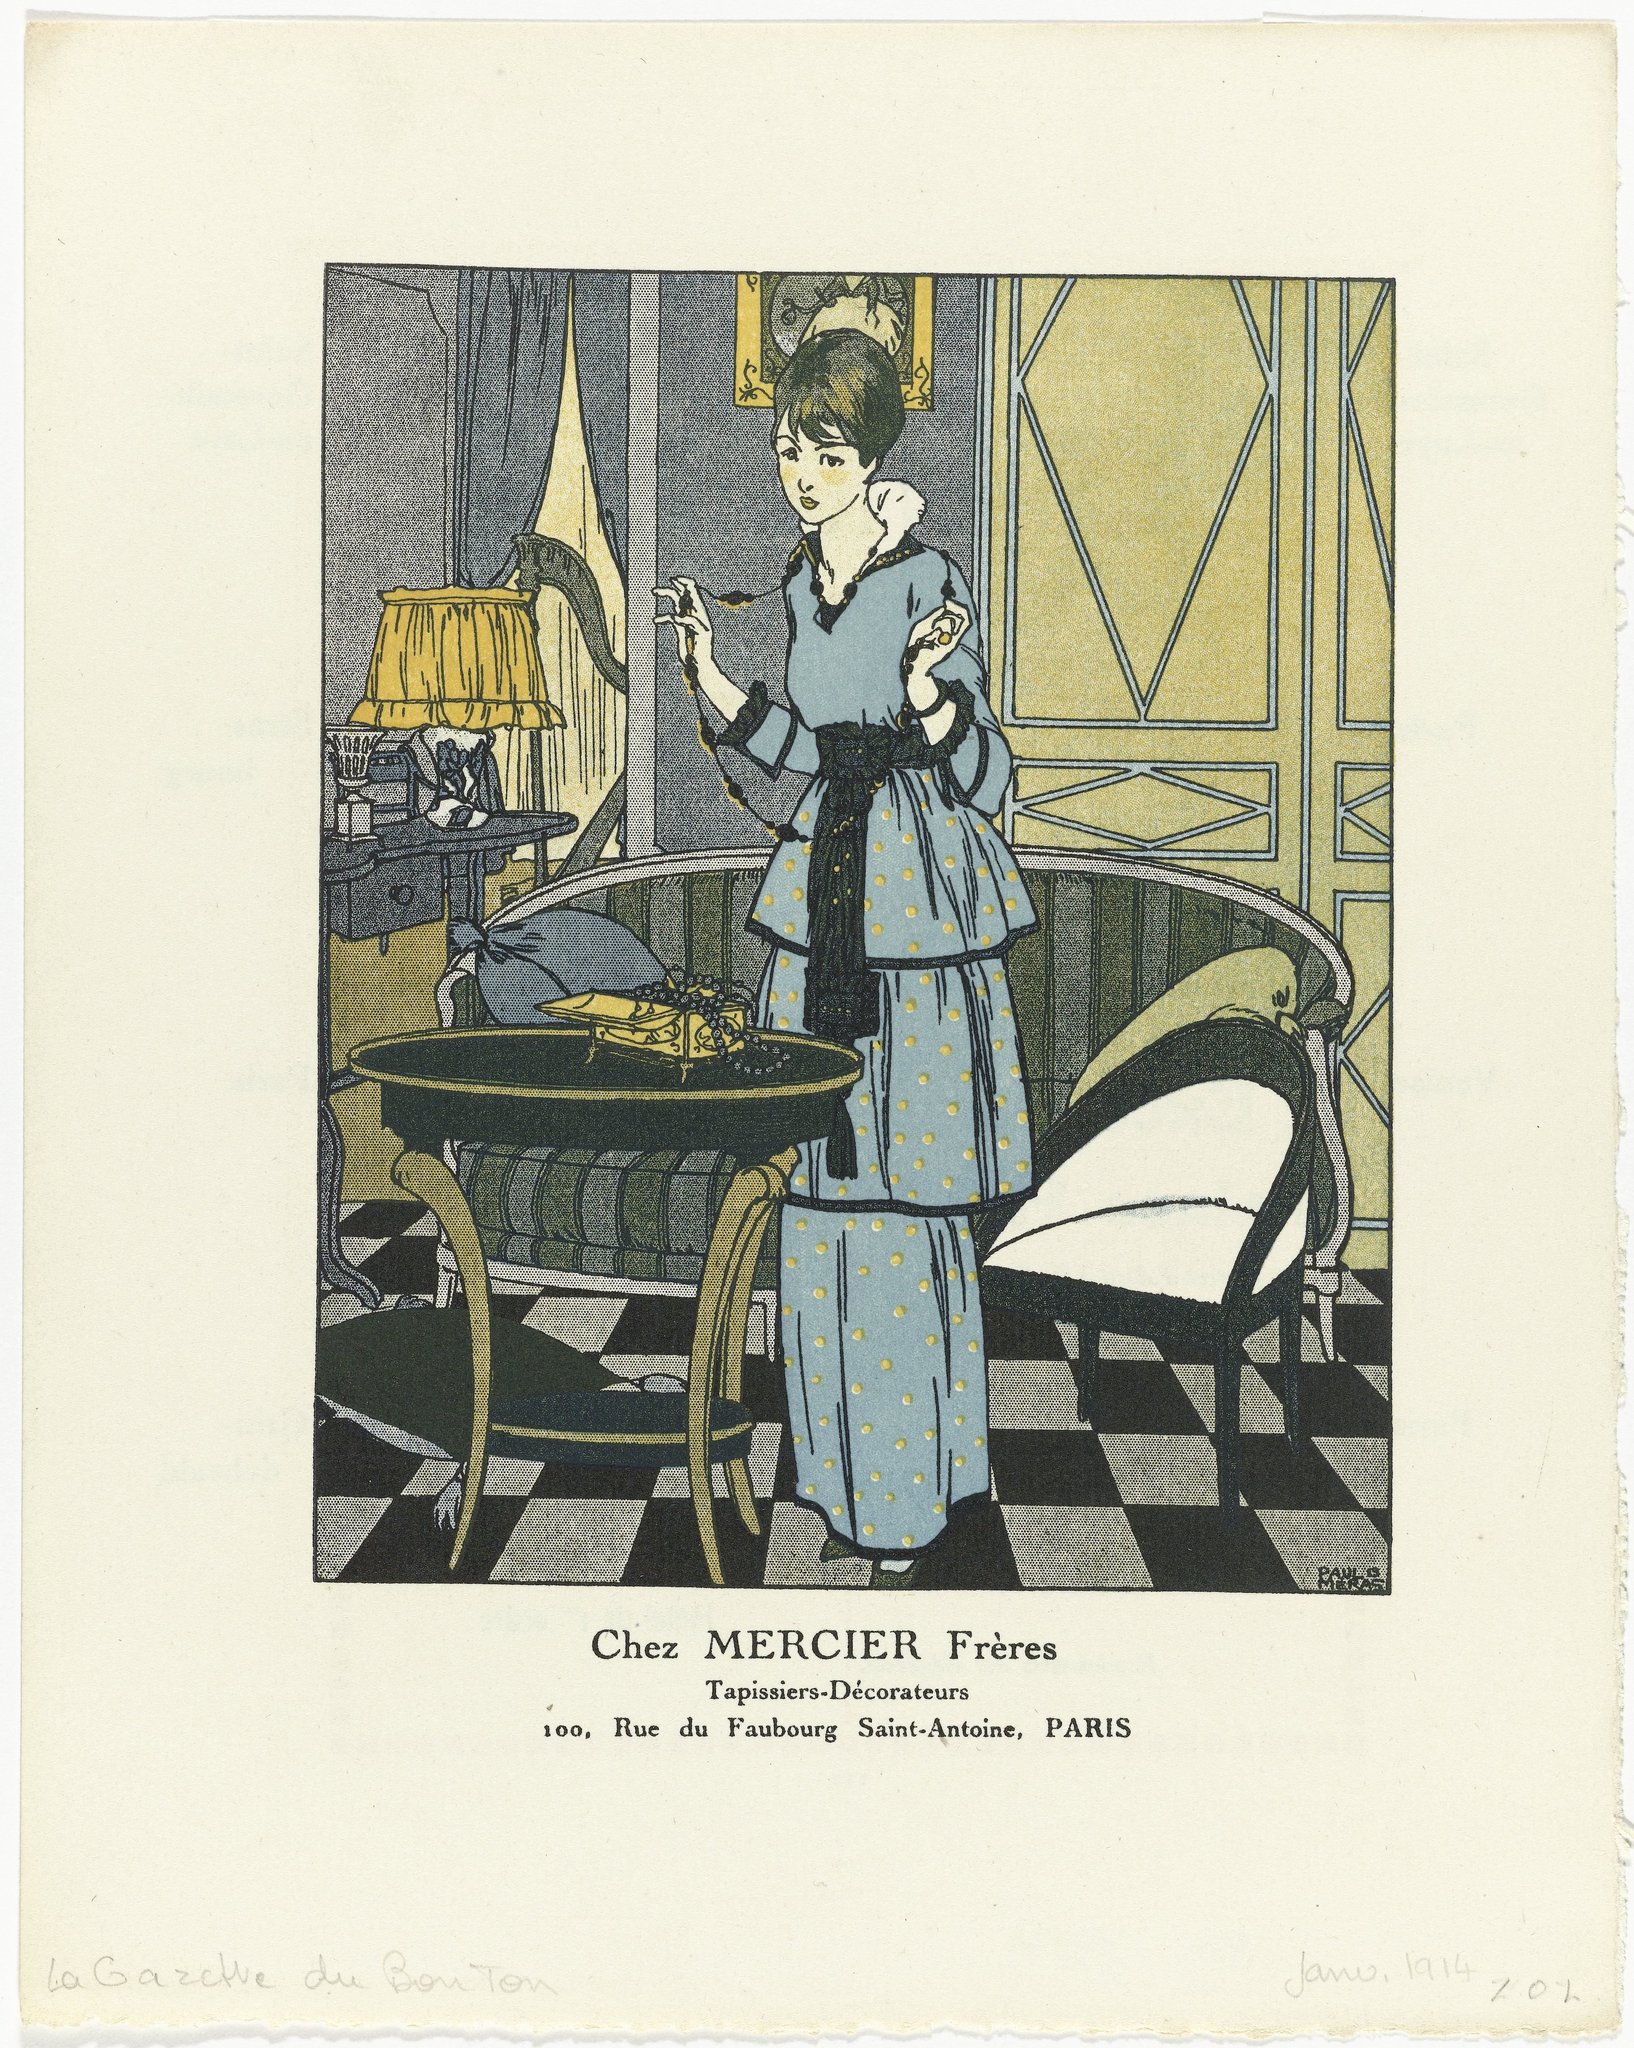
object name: fashion print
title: Gazette du Bon Ton, 1914 - No. 1: Chez MERCIER Frères / Tapissiers - Décorateurs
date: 1914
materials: paper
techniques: printing, letterpress printing, photochemical processes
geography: paris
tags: jewel-box (+ women's clothes), fashion plates, dress, gown (+ women's clothes), interior of the house, advertisement, notice, necklace (+ women's clothes), belt, girdle, waistband (+ women's clothes)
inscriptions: caption: ‘Chez MERCIER Frères / Tapissiers- Décorateurs’, title: ‘Les plus grands hotels (...)’, address: ‘100, Rue du Faubourg Saint-Antoine, PARIS’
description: Vrouw in een interieur van de firma Mercier, stoffeerders en decorateurs. Zij draagt een jurk met een gestippelde strokenrok. In de handen een lang kralencollier. Op de salontafel staat een juwelendoos. Op de achtergrond een stoel, sofa en harp. Verso: een advertentie van zeven verschillende hotels.